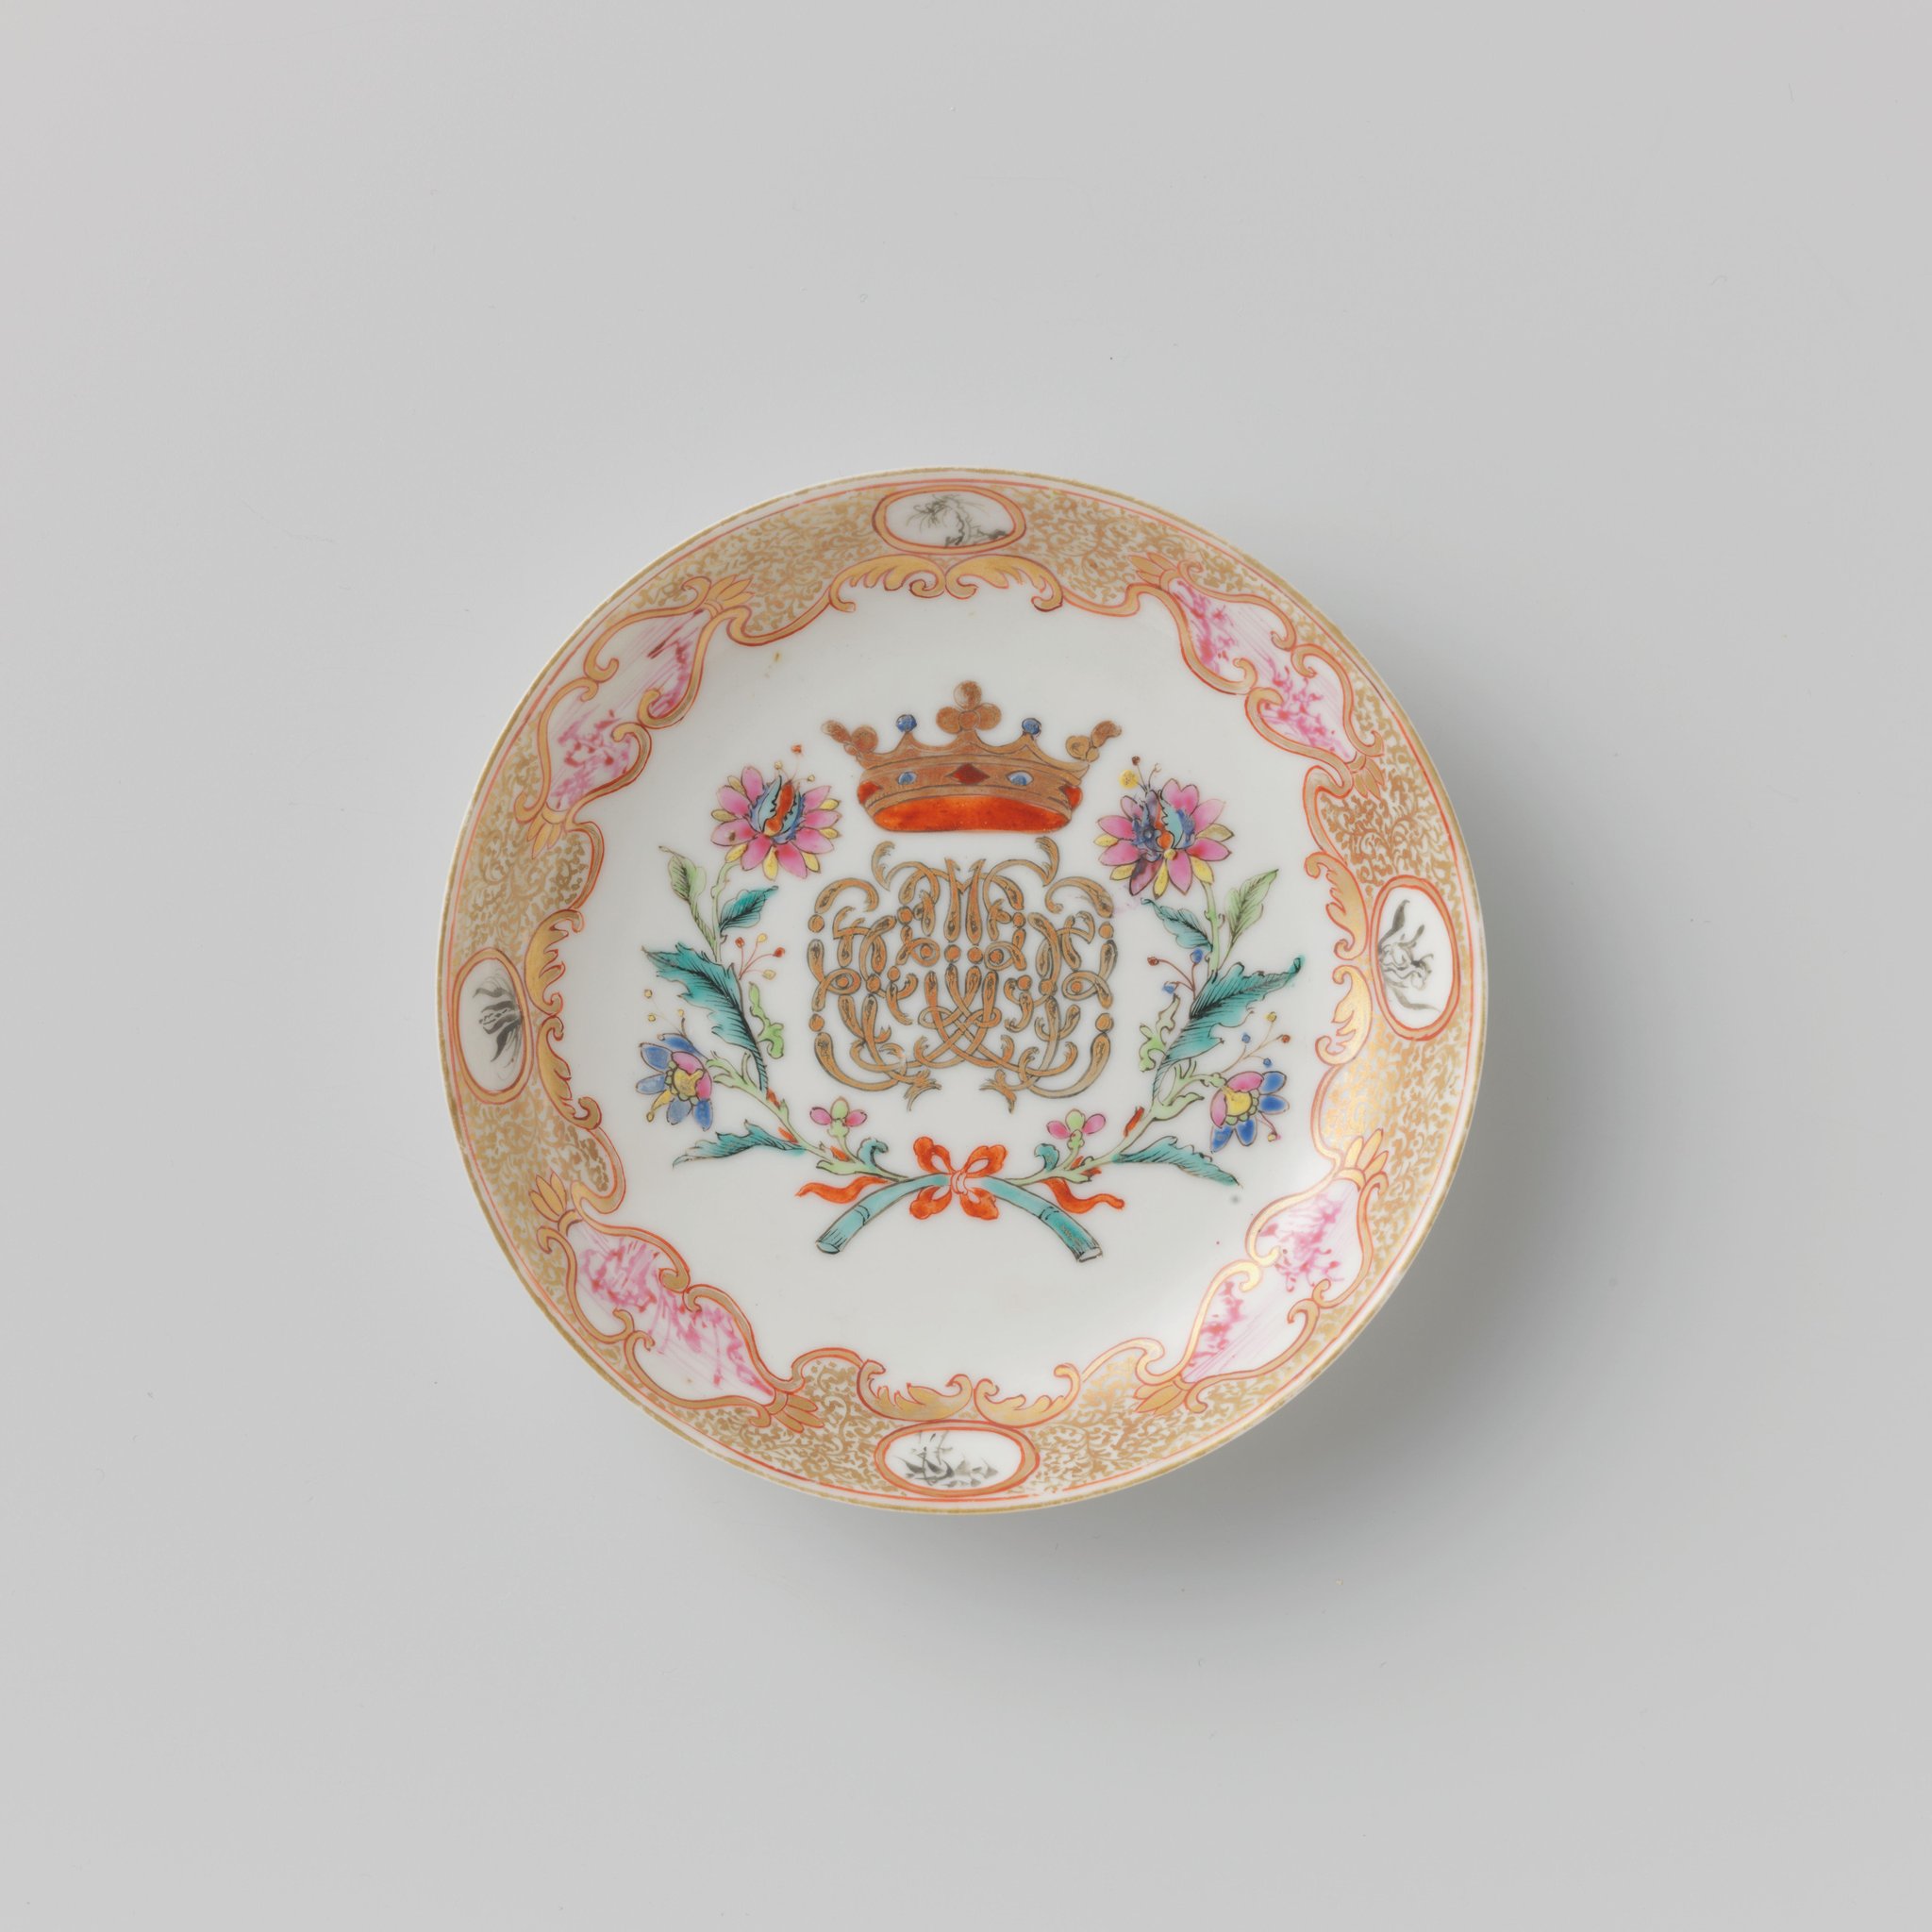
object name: platter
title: Saucer with a crowned, illegible monogram surrounded by two flower sprays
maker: Anonymous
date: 1750-1774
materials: glaze, gold, paint, porcelain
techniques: firing, gilding, turning, vitrification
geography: china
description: Schotel van porselein, beschilderd op het glazuur in blauw, rood, roze, groen, geel, zwart en goud. Op het plat een gekroond, onleesbaar monogram omringd door twee bloemtakken; de wand met bloemranken met daarin uitgespaard vier cartouches met een landschap en vier medaillons met planten. Europese voorstelling in emailkleuren.